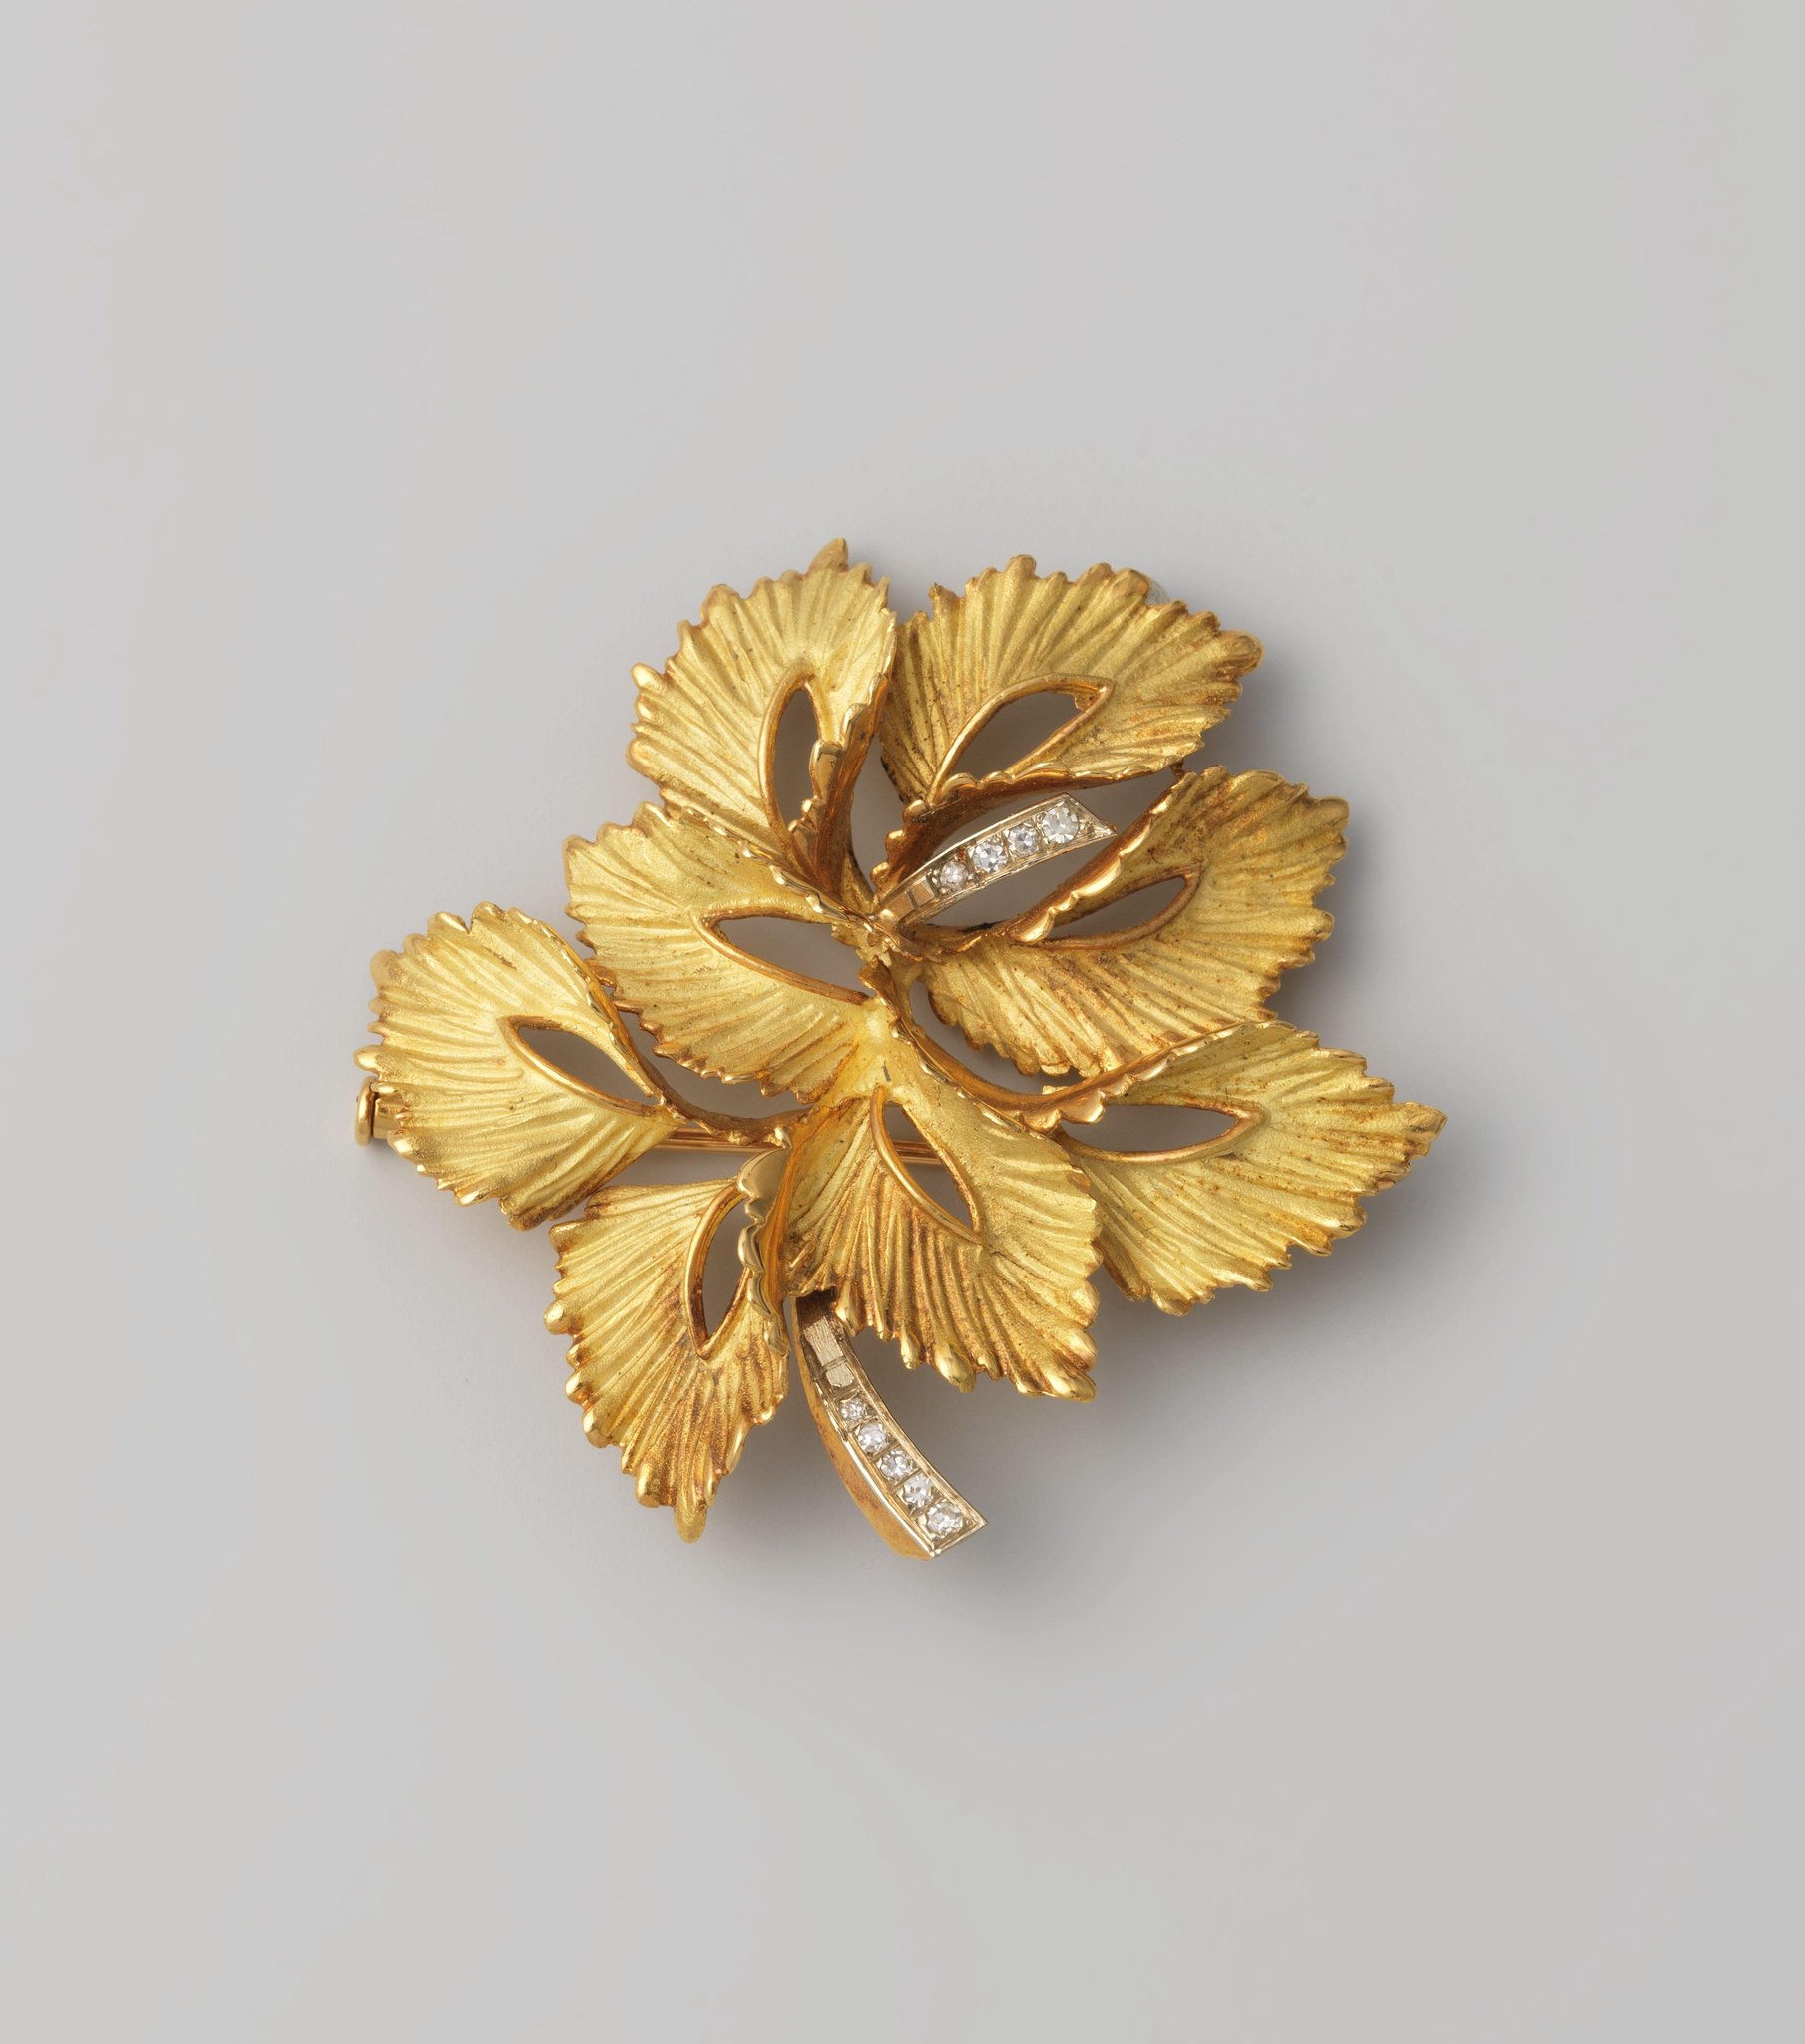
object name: brooch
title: Flower Brooch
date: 1970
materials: diamond, gold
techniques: grinding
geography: amsterdam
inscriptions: alloy mark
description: Gematteerde takbroche van goud met twee schakels pavé bezet met één maal vier en één maal vijf diamanten achtkant voorzien van een kanonsluiting. De randen van de bladeren zijn poli, evenals de achterzijde.